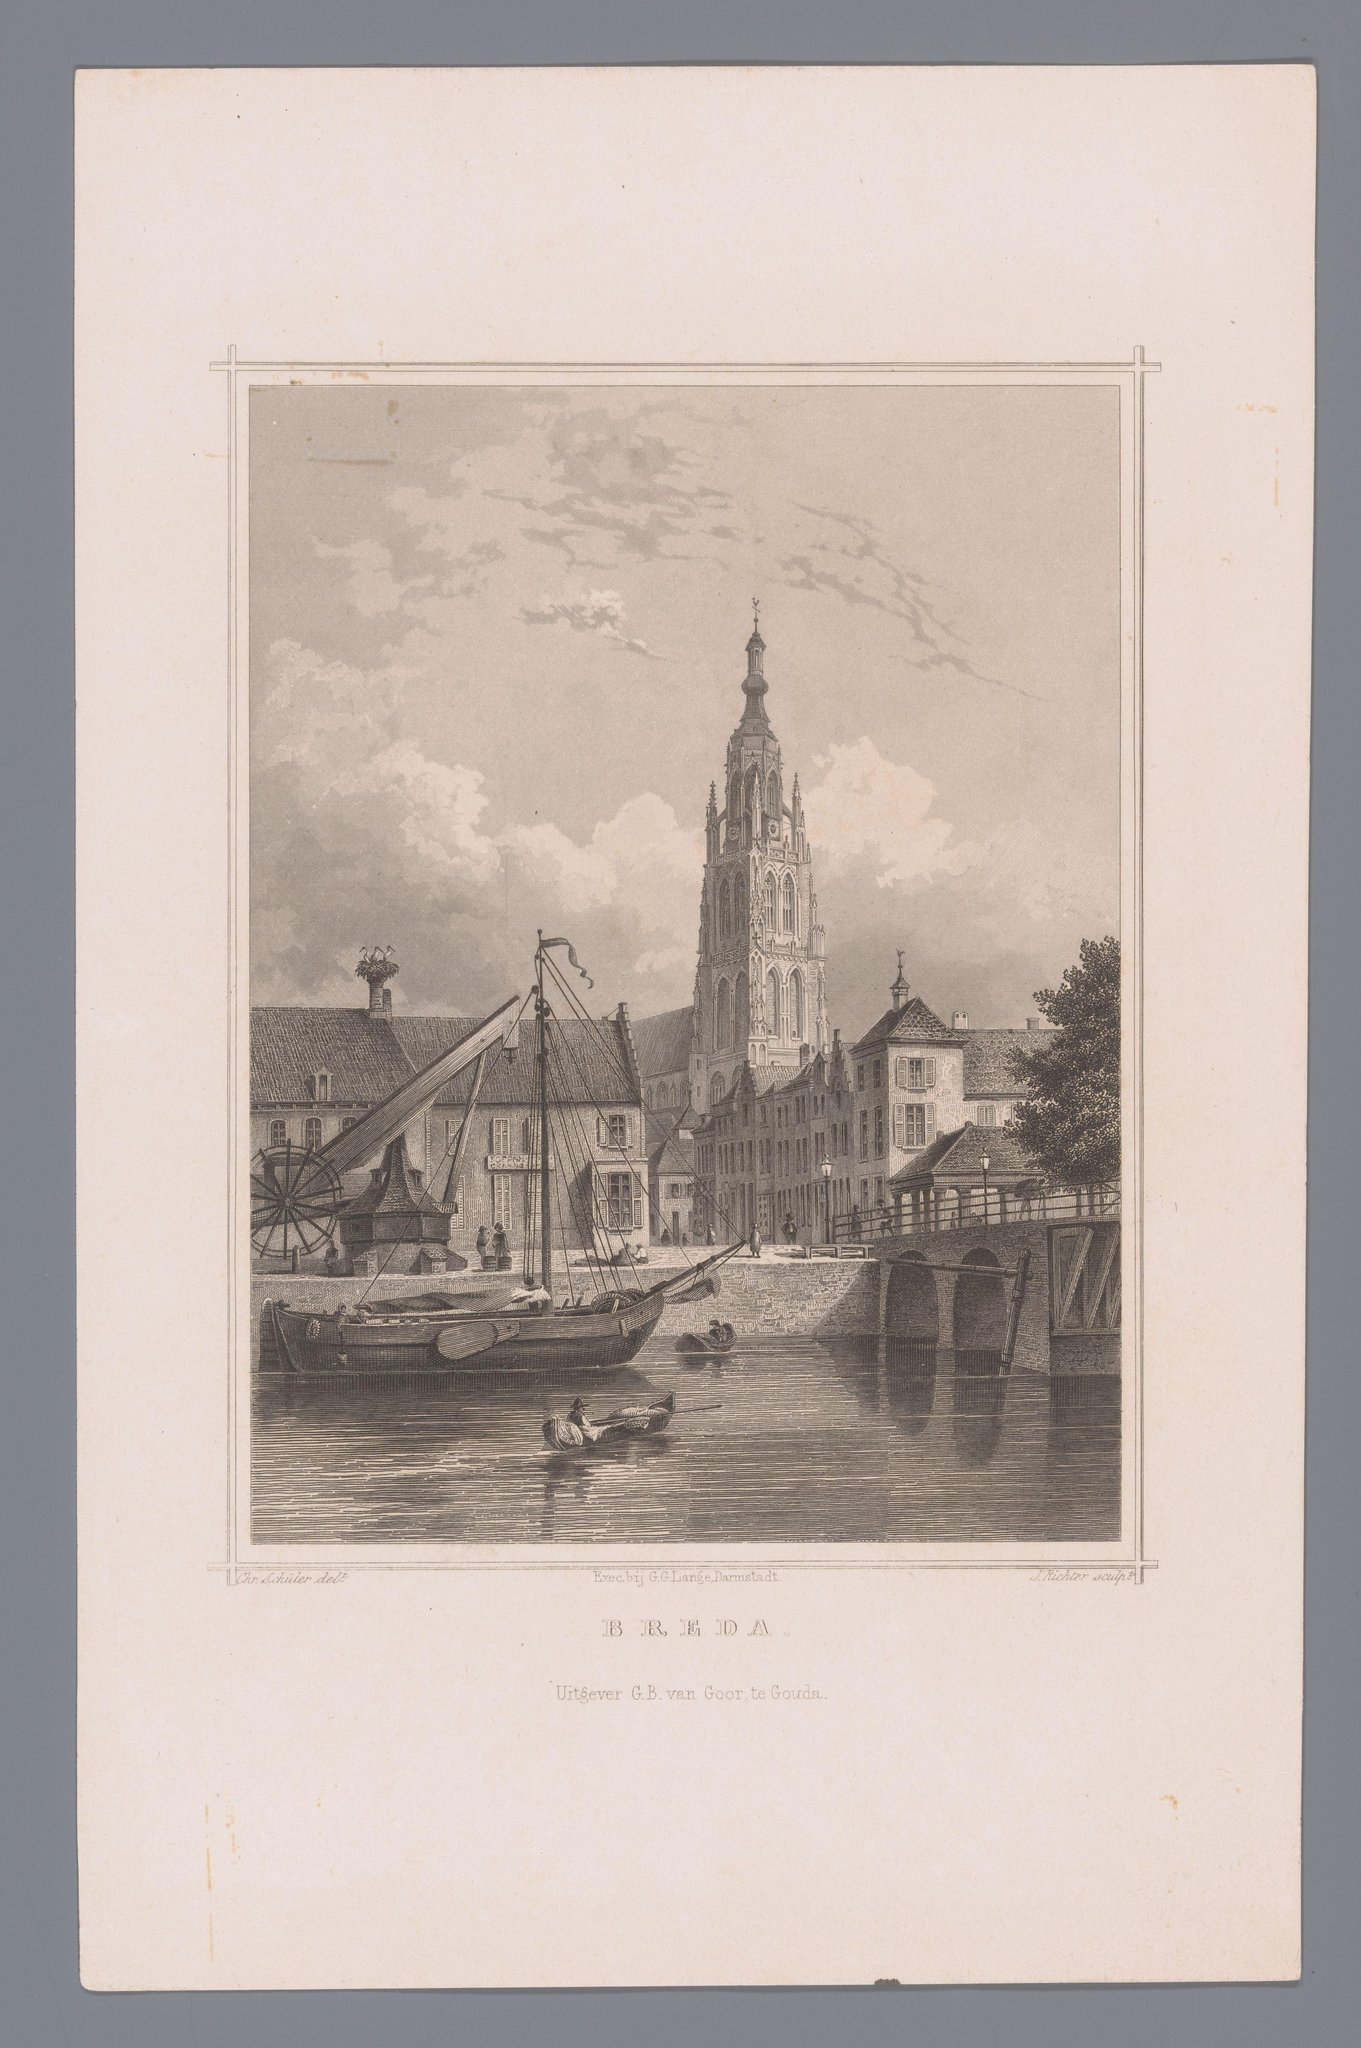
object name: book illustration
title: Gezicht op Breda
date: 1857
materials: paper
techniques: engraving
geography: gouda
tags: sailing-ship, sailing-boat, church (exterior), bridge in city across river, canal, etc.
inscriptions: collector's mark: Lugt 2228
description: Prent uit: Terwen, J.L. Het koningrijk der Nederlanden (...). 2 dln. Gouda: G.B. van Goor, 1857, p. 430-431. Dezelfde prent, met een ander onderschrift, komt ook voor in: Der Rhein und die Rheinlande in malerischen Original-ansichten. 3 dln. Darmstadt: G.G. Lange, 1863.